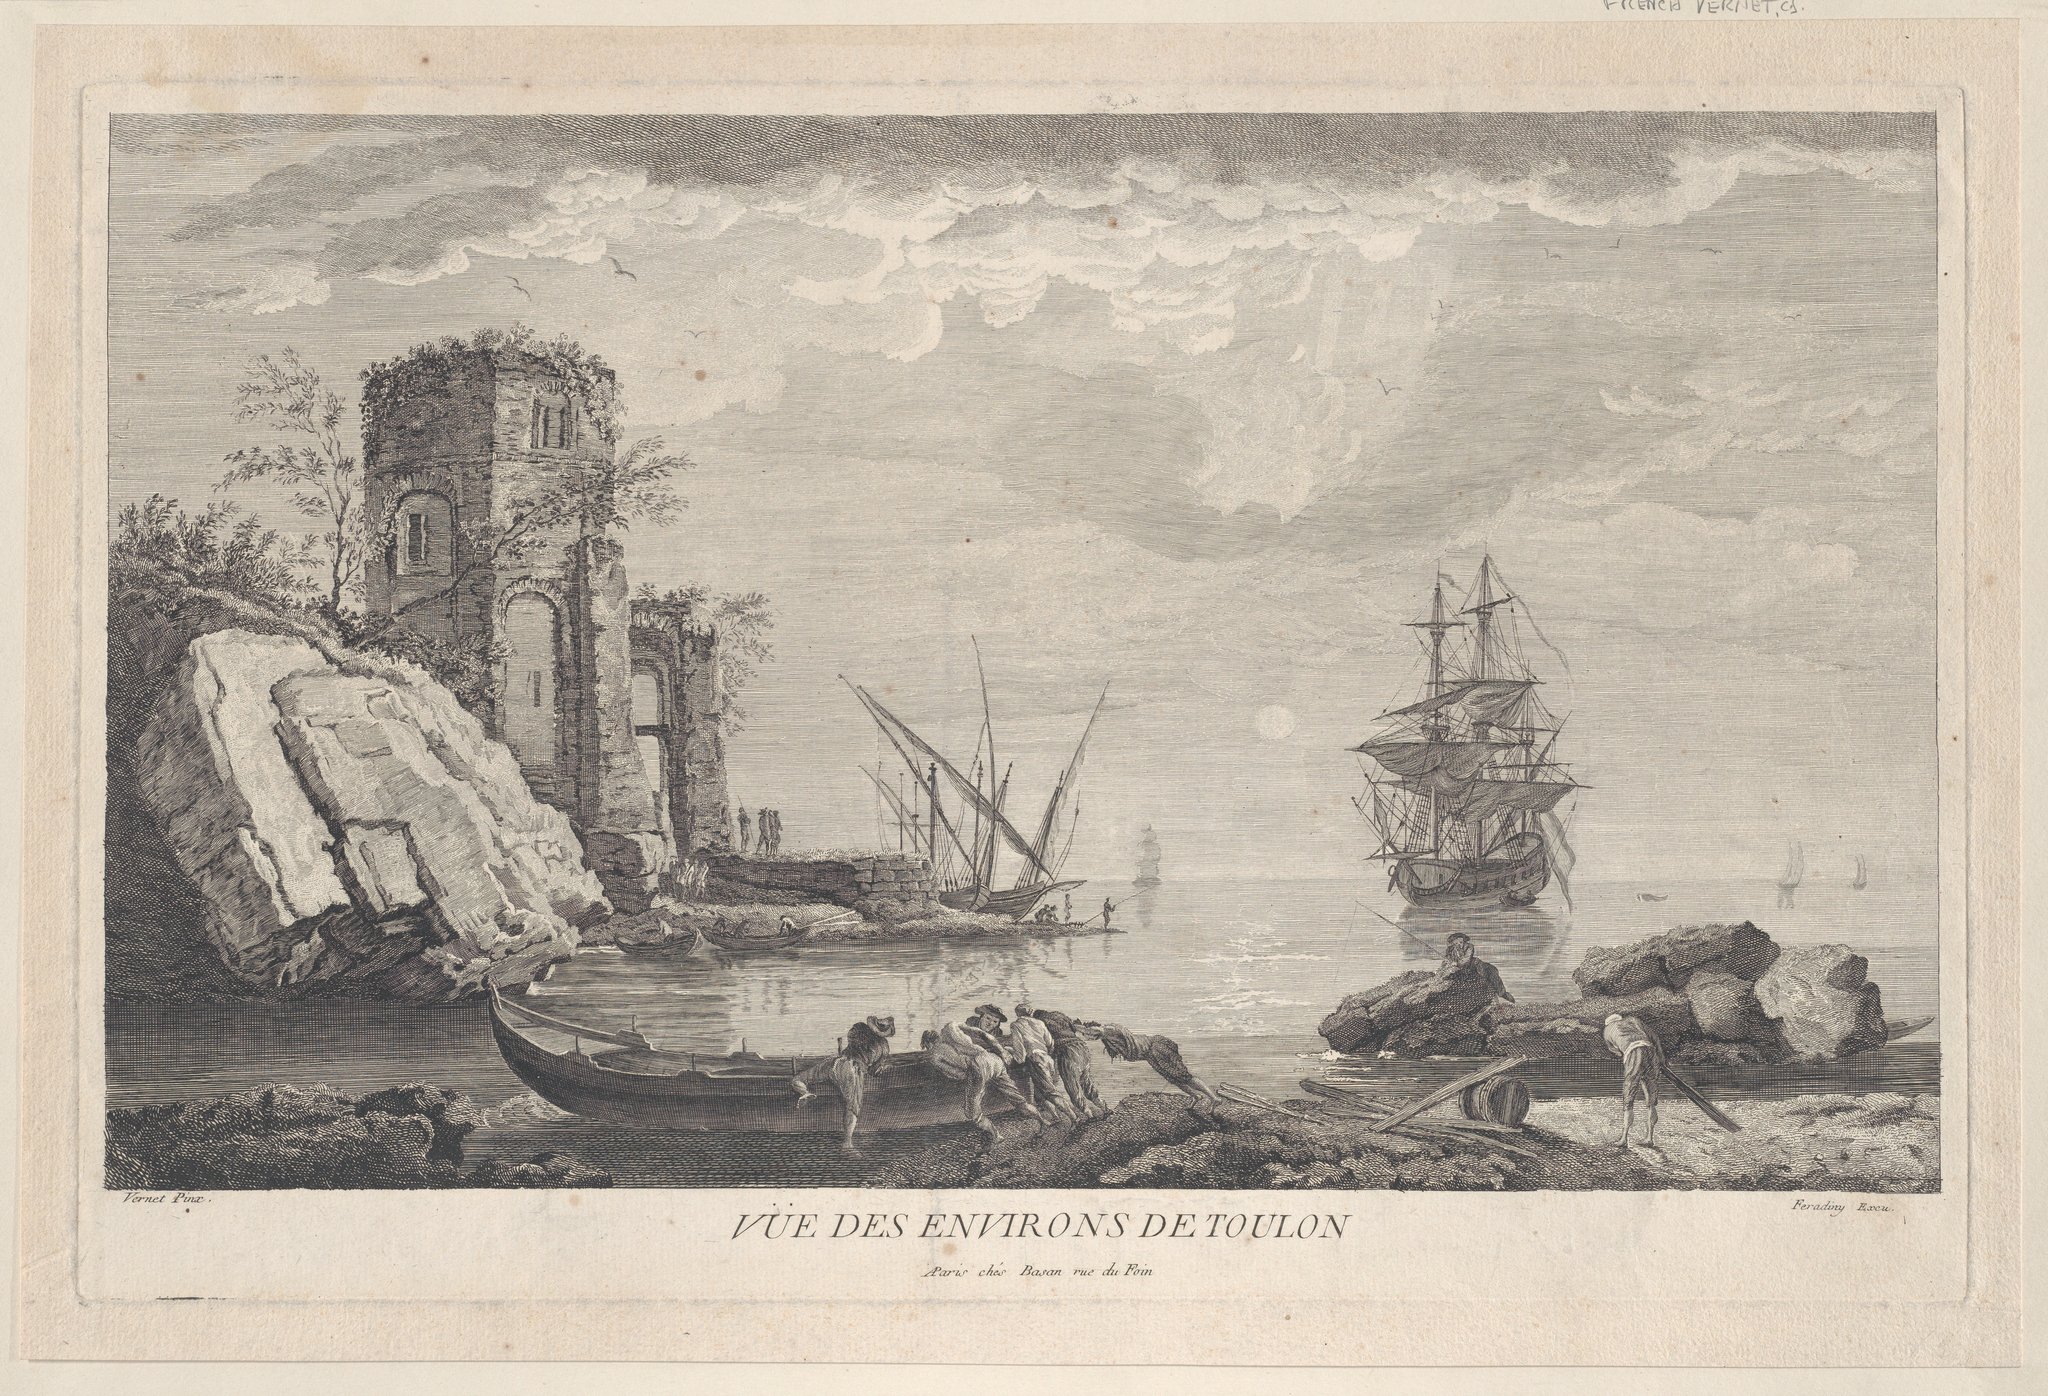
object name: print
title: View of the Surroundings of Toulon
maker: joseph vernet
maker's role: artist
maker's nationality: french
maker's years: 1714-1789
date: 1750-1800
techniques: engraving